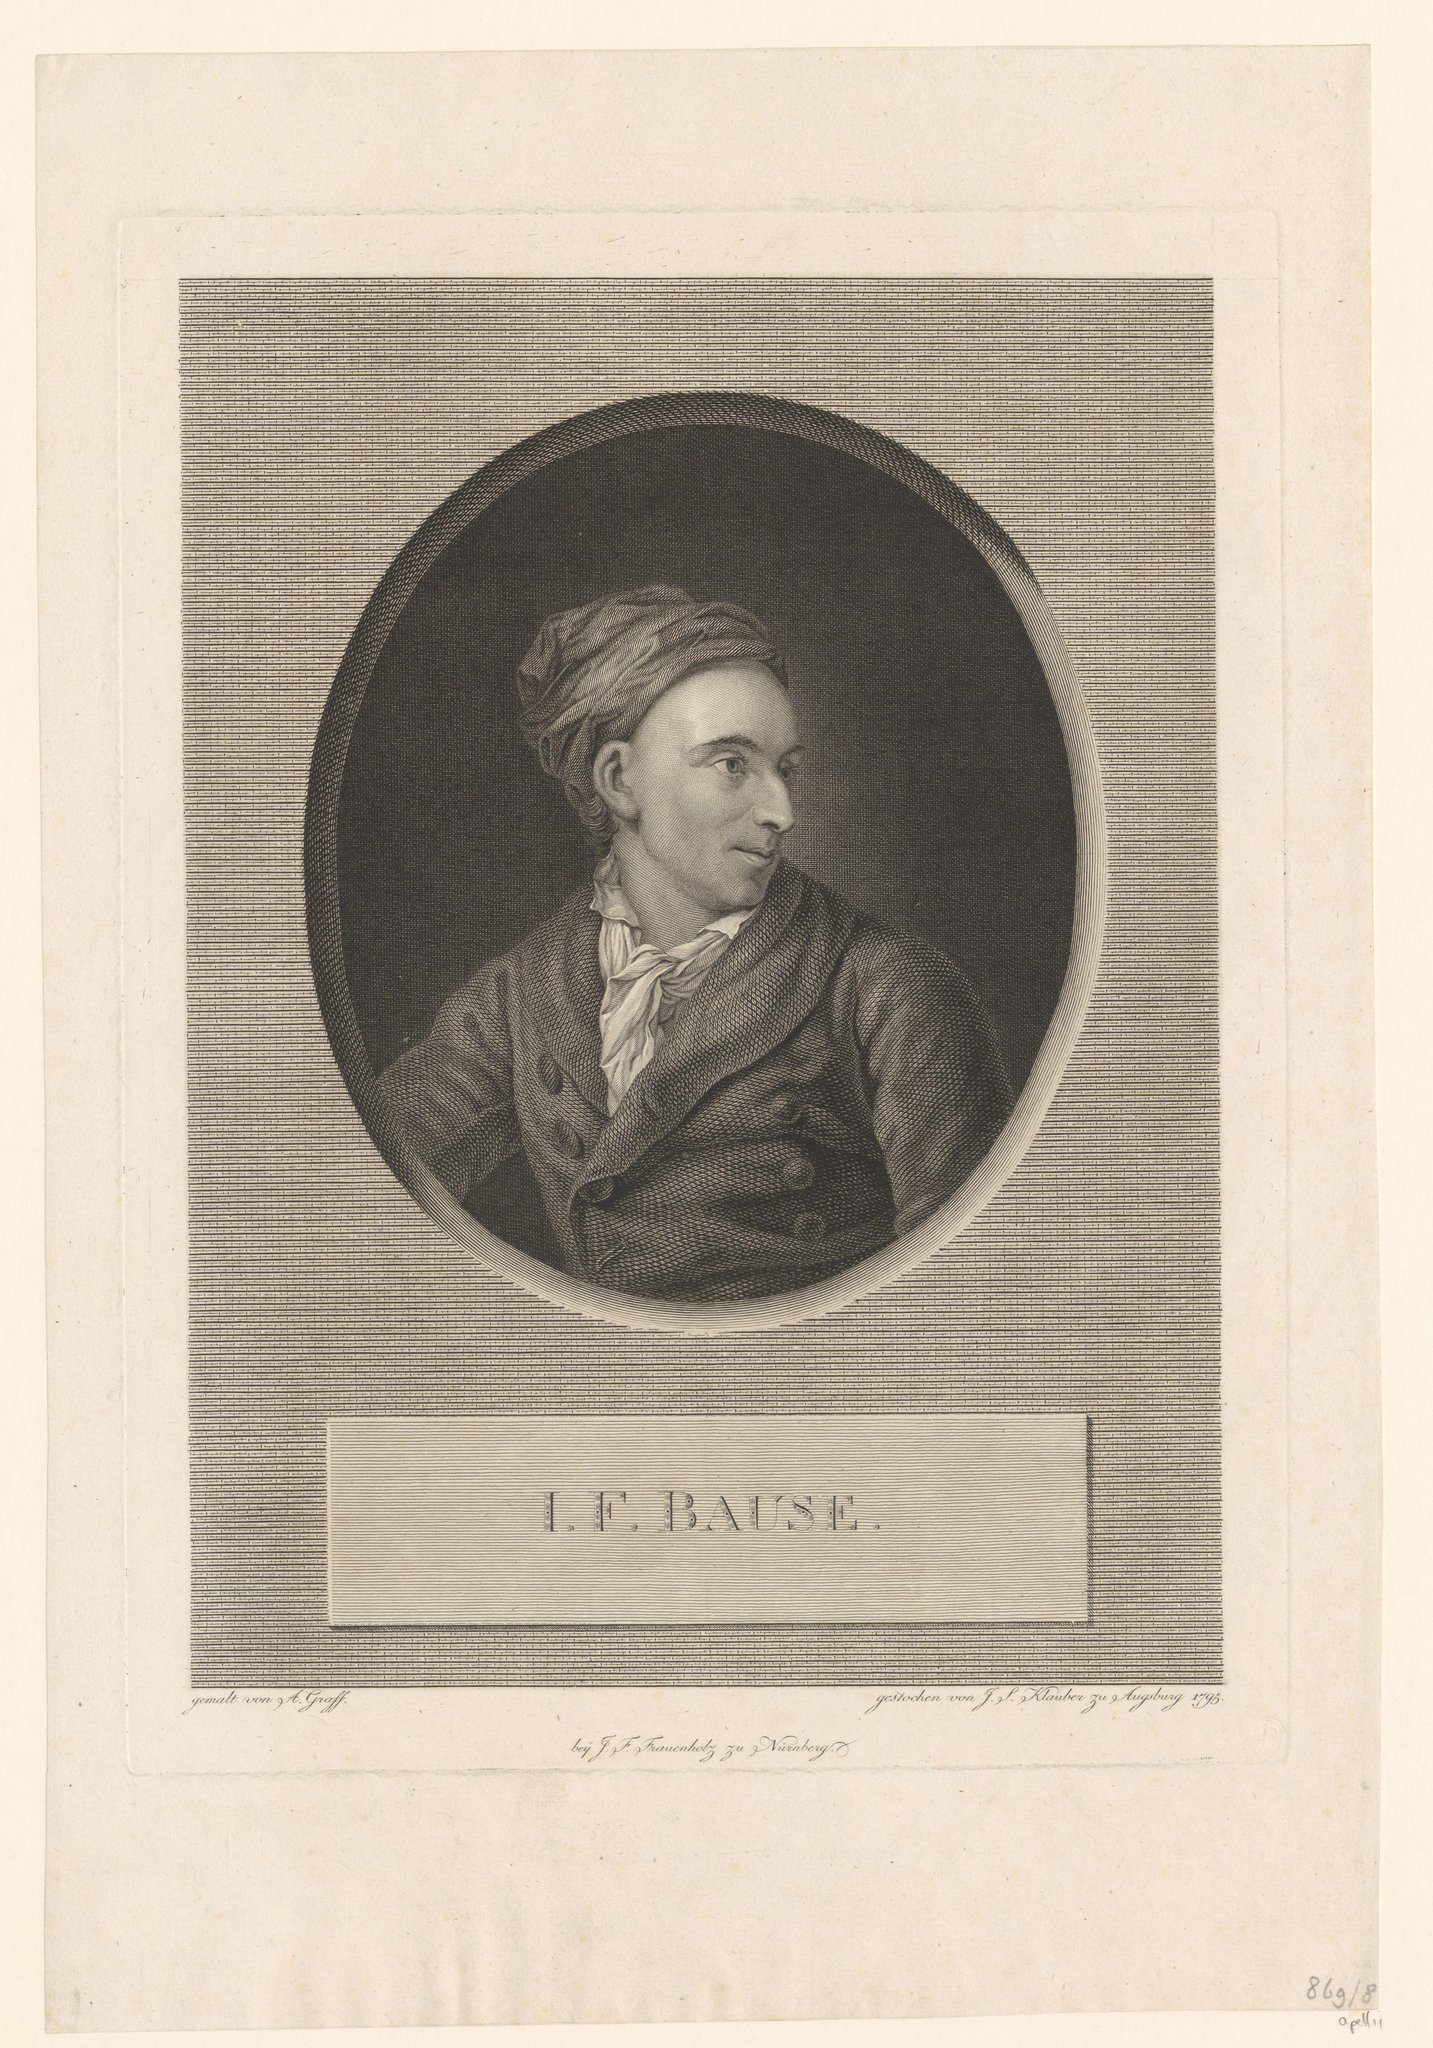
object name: print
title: Portret van Johann Friedrich Bause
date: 1795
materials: paper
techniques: engraving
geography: nuremberg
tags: draughtsman, johann friedrich bause, historical persons, portrait, self-portrait of graphic artist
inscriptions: collector's mark: Lugt 994, collector's mark: Lugt 2228, collector's mark: Lugt 2760